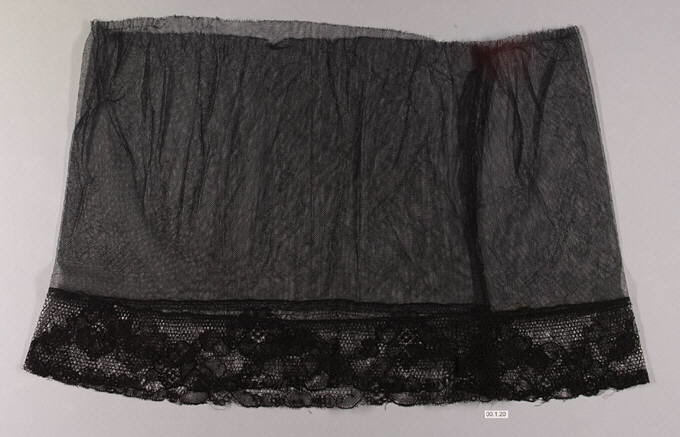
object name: fragment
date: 1801-1900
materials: silk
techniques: lace